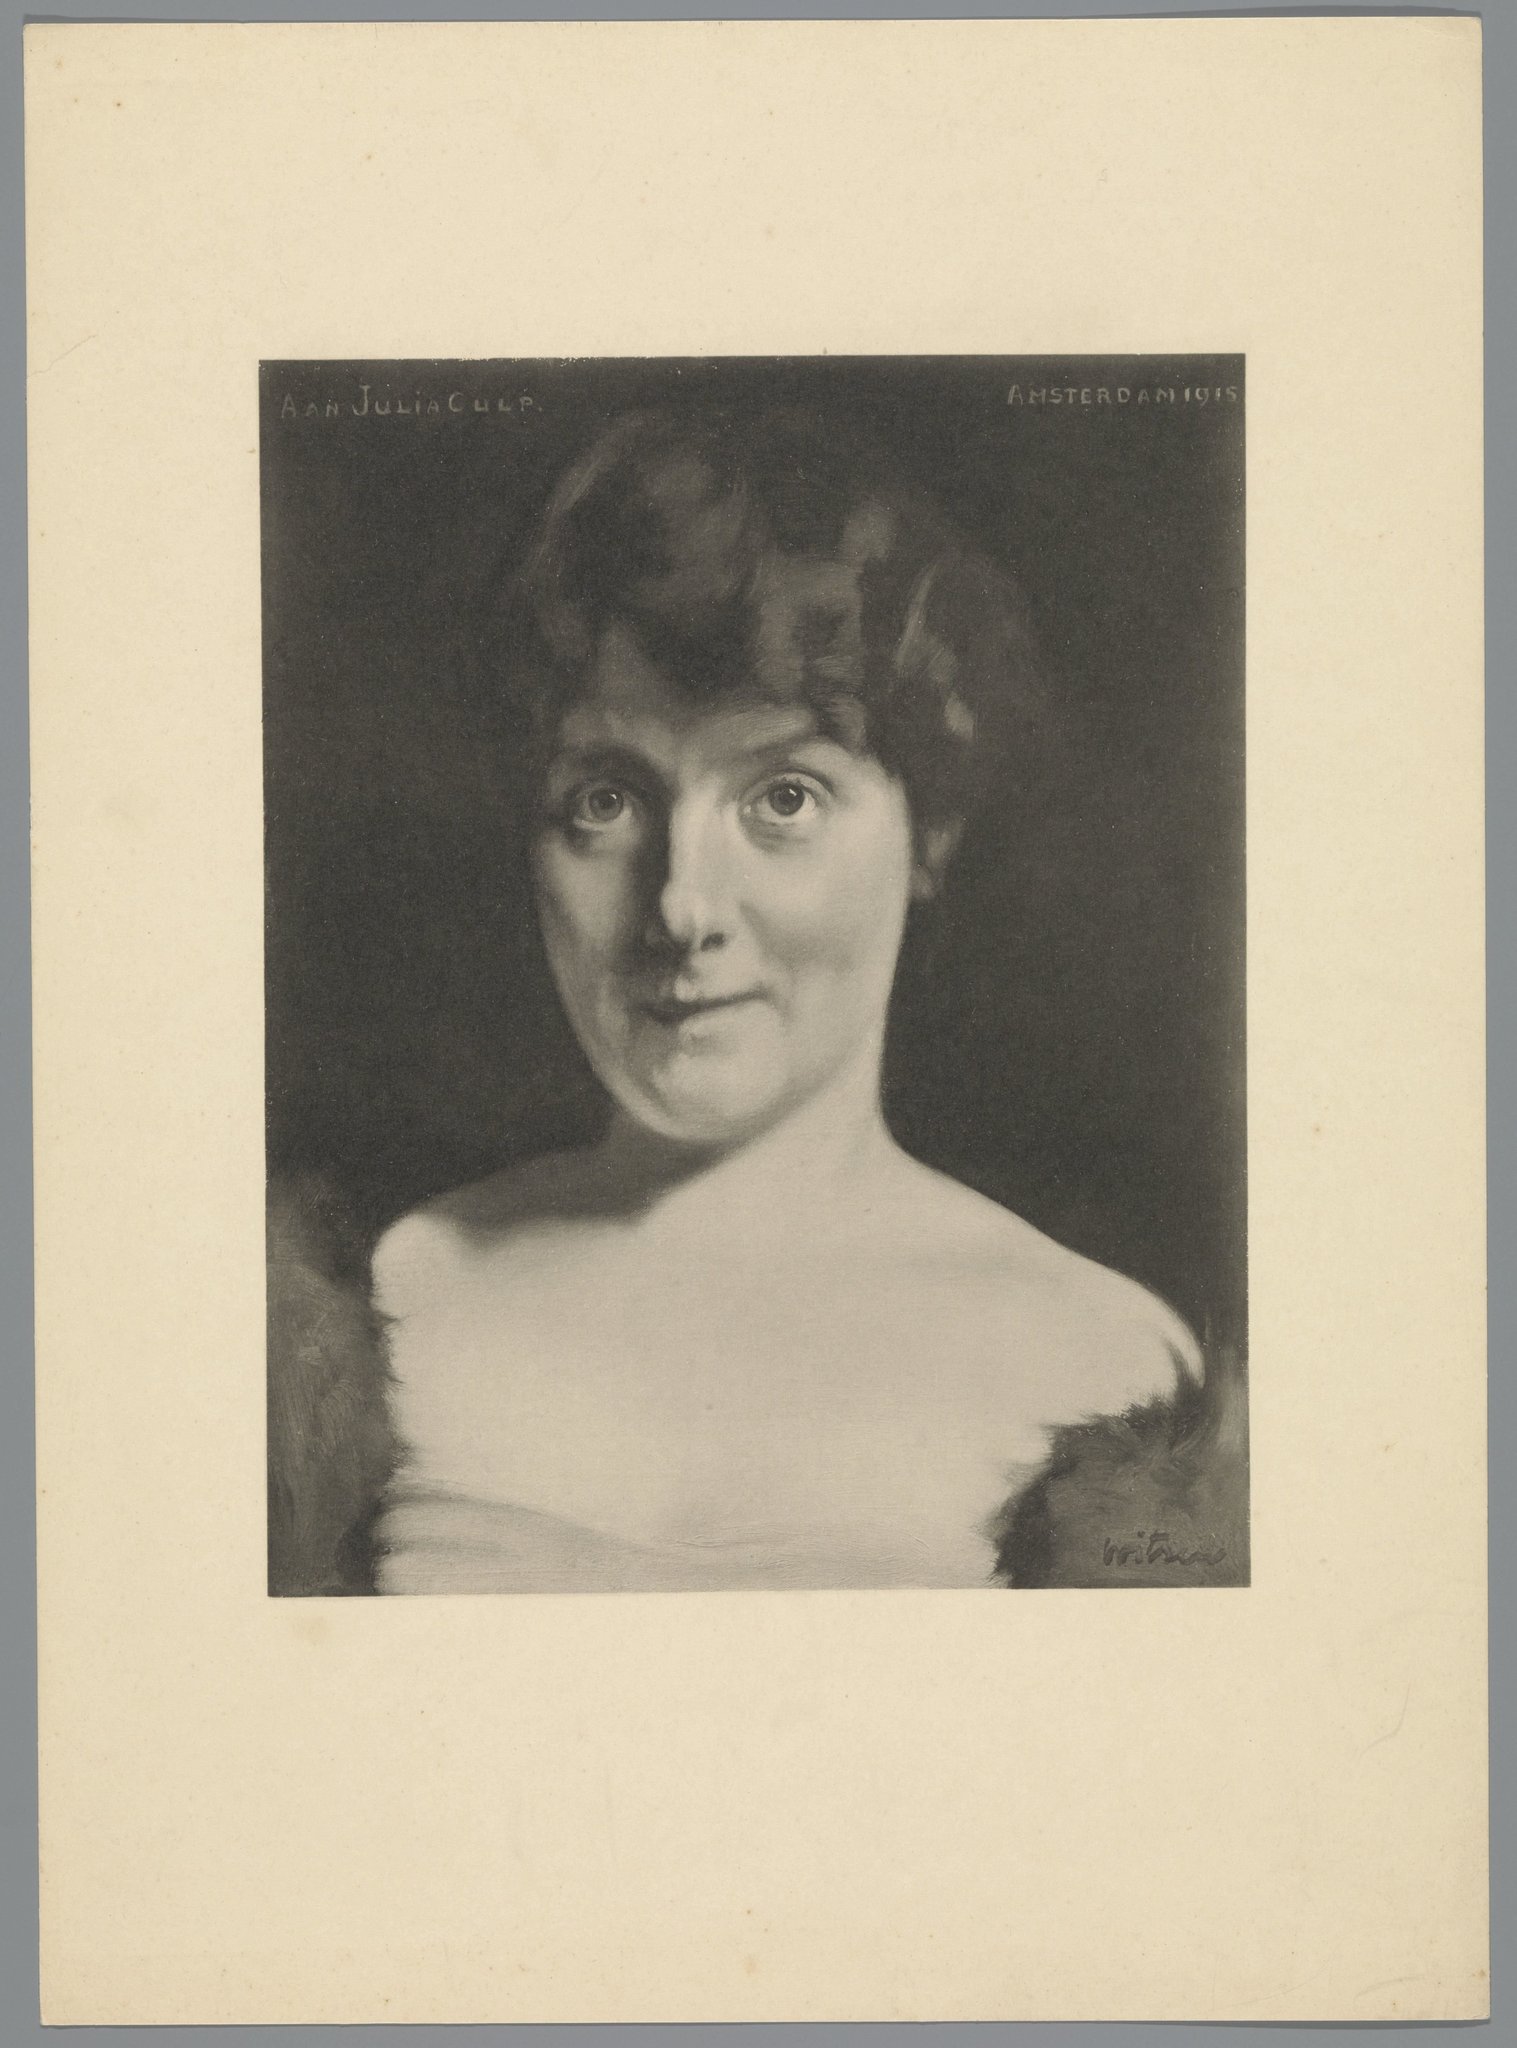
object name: print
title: Reproductie naar schilderij met portret van Julia Culp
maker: Anonymous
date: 1915-1925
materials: paper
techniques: photograph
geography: netherlands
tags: amsterdam